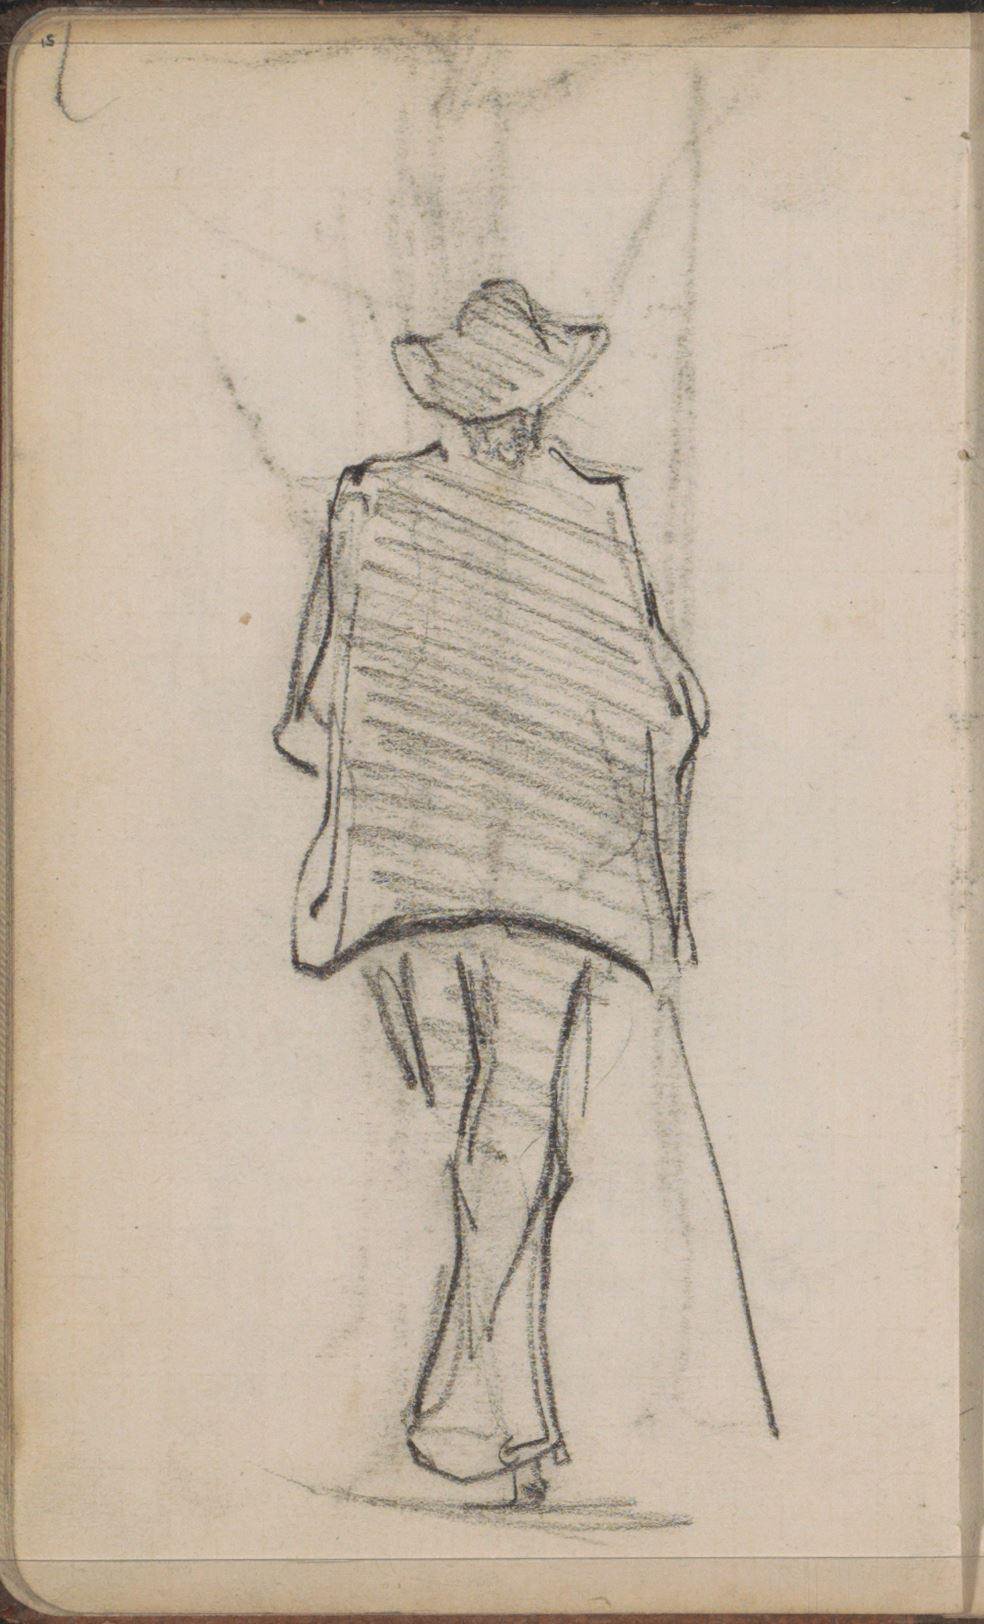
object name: sketchbook leaf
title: Staande man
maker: marius bauer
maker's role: draughtsman, print maker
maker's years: 1867-1932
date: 1879-1885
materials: chalk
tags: standing figure, walking-stick, staff, adult man, head-gear: hat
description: De man is van achteren gezien getekend, met een wandelstok en hoed. Pagina 15 uit een schetsboek met 58 bladen.